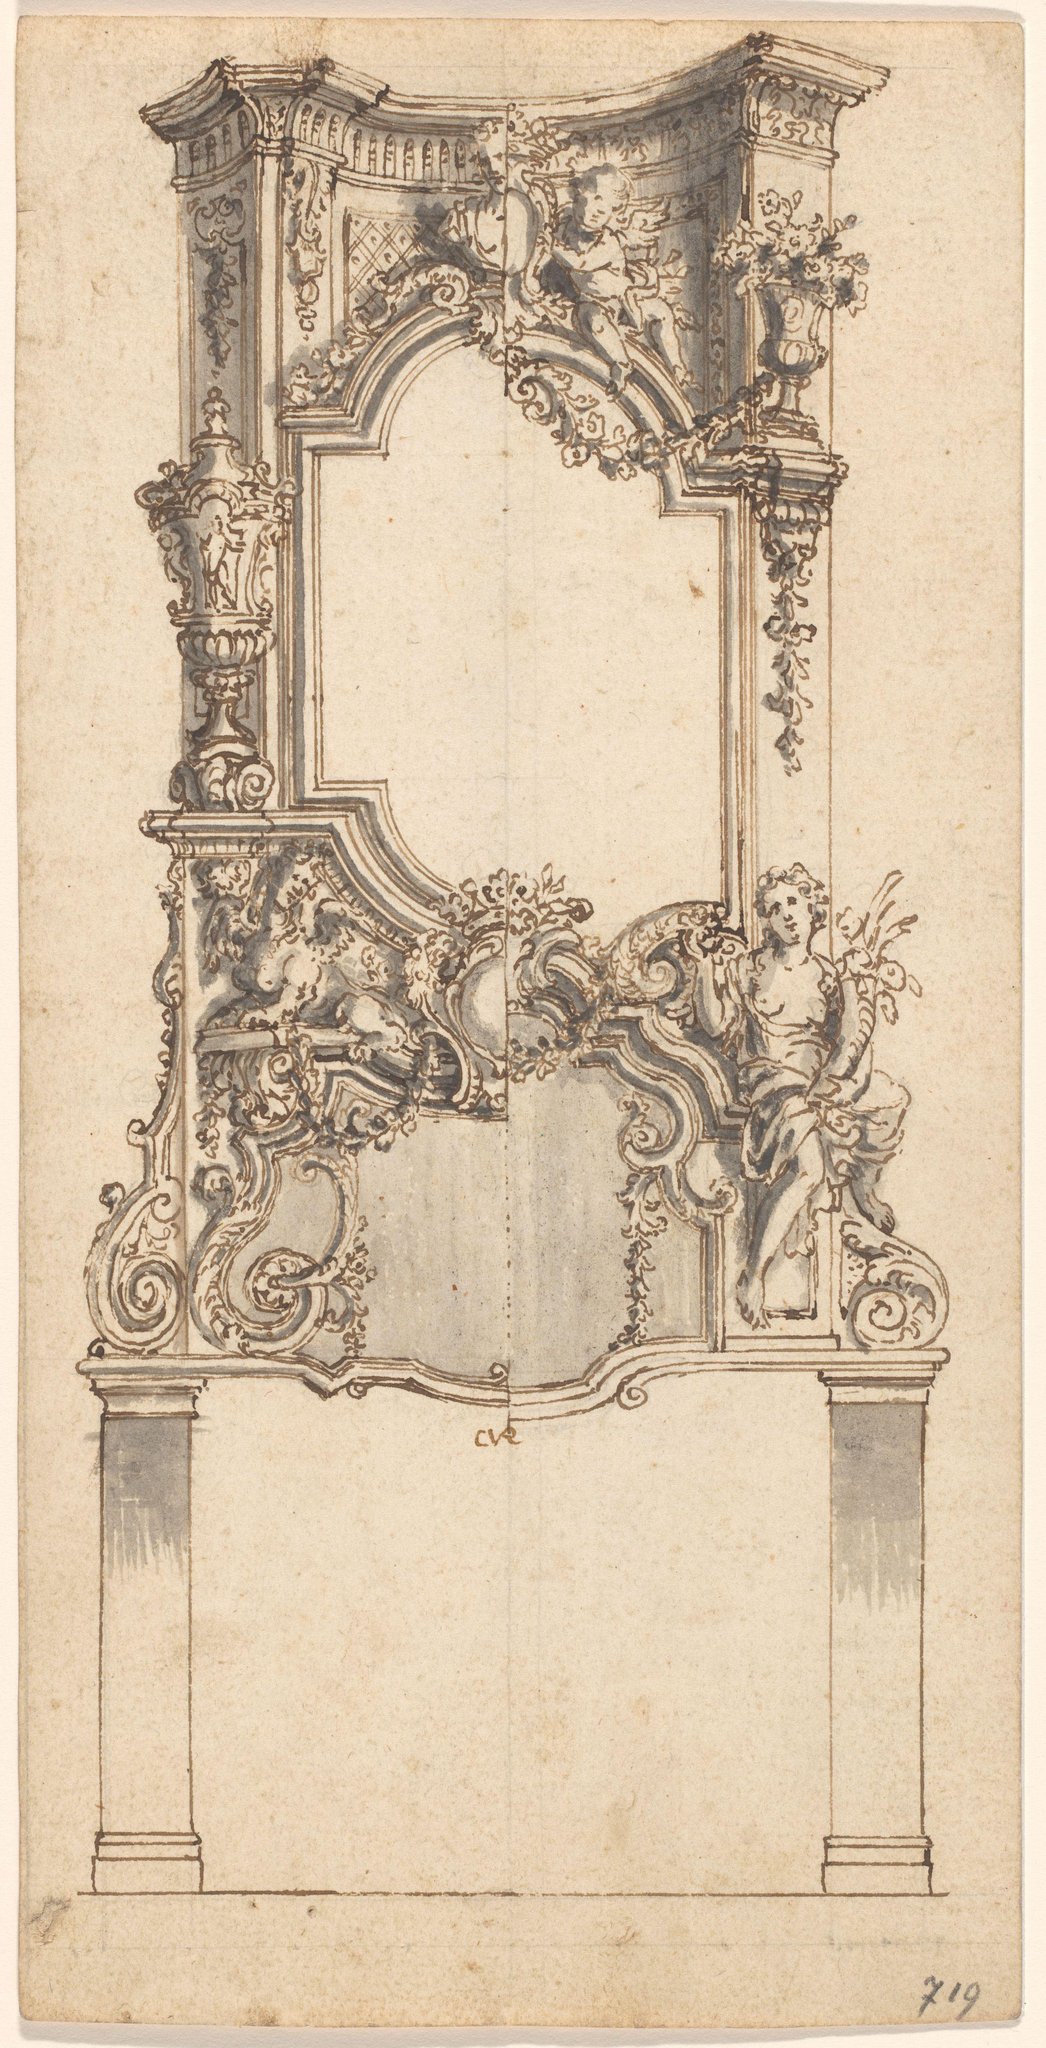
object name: drawing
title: Ontwerp voor een schoorsteenmantel met een spiegel waarboven een ruimte voor een schildering, met in de twee helften twee alternatieve oplossingen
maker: Anonymous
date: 1710-1730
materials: graphite, ink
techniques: brush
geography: netherlands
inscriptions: inscription: ‘214’, inscription: ‘719’, inscription: ‘CVR (VR aaneen)’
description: In verso: deel van een schets in zwart krijt.